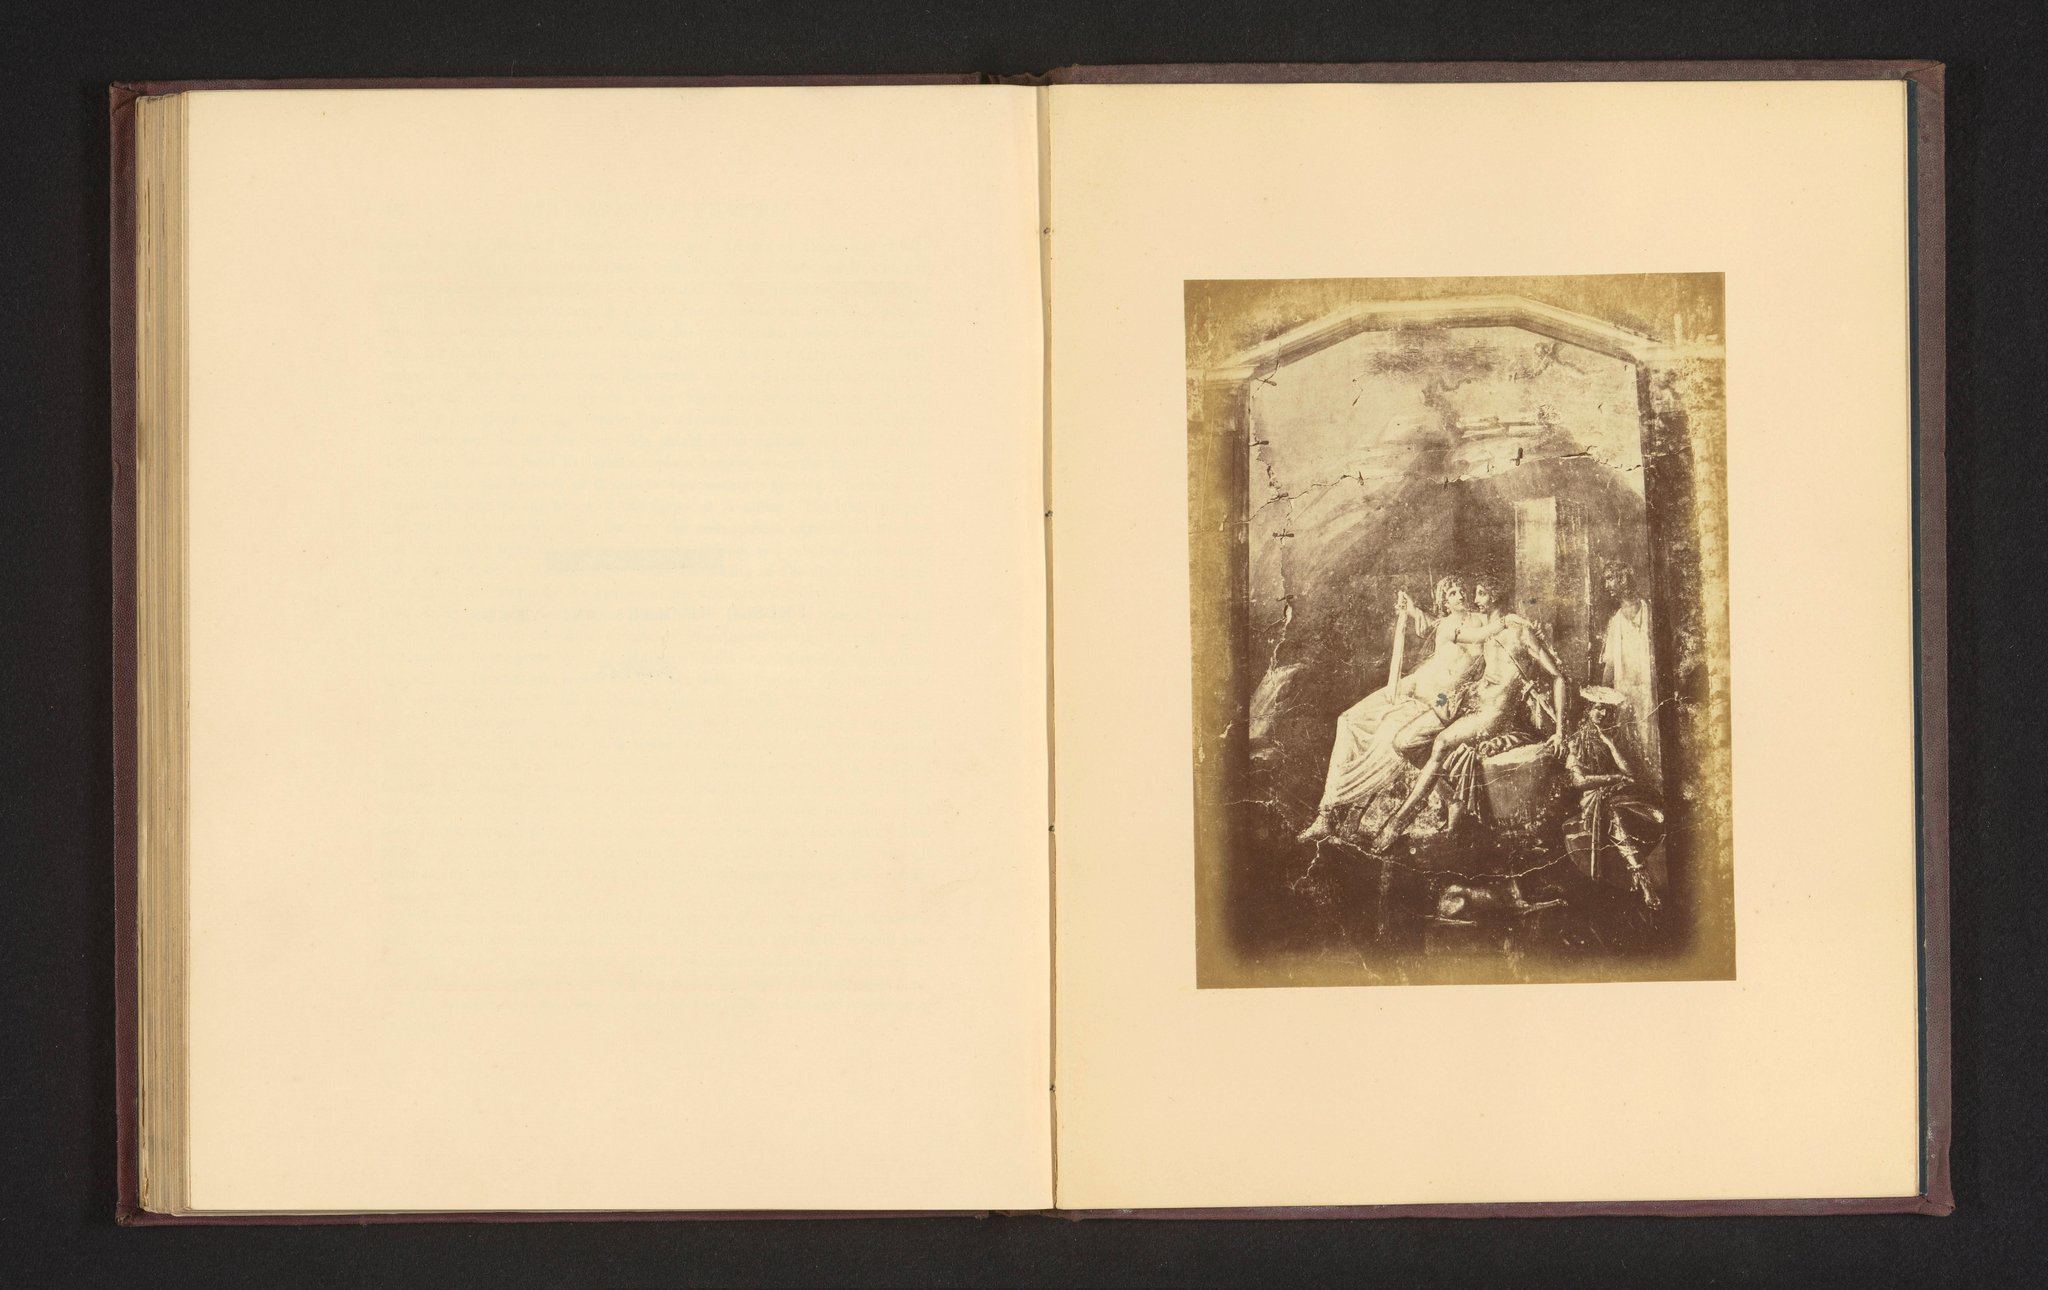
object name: photograph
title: Gezicht op een fresco van Mars en Venus te Pompeï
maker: Anonymous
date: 1862-1867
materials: cardboard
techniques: albumen print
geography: pompeii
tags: painting, drawing and the graphic arts, pompeii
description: Foto op derde ongenummerde pagina na pagina 106.